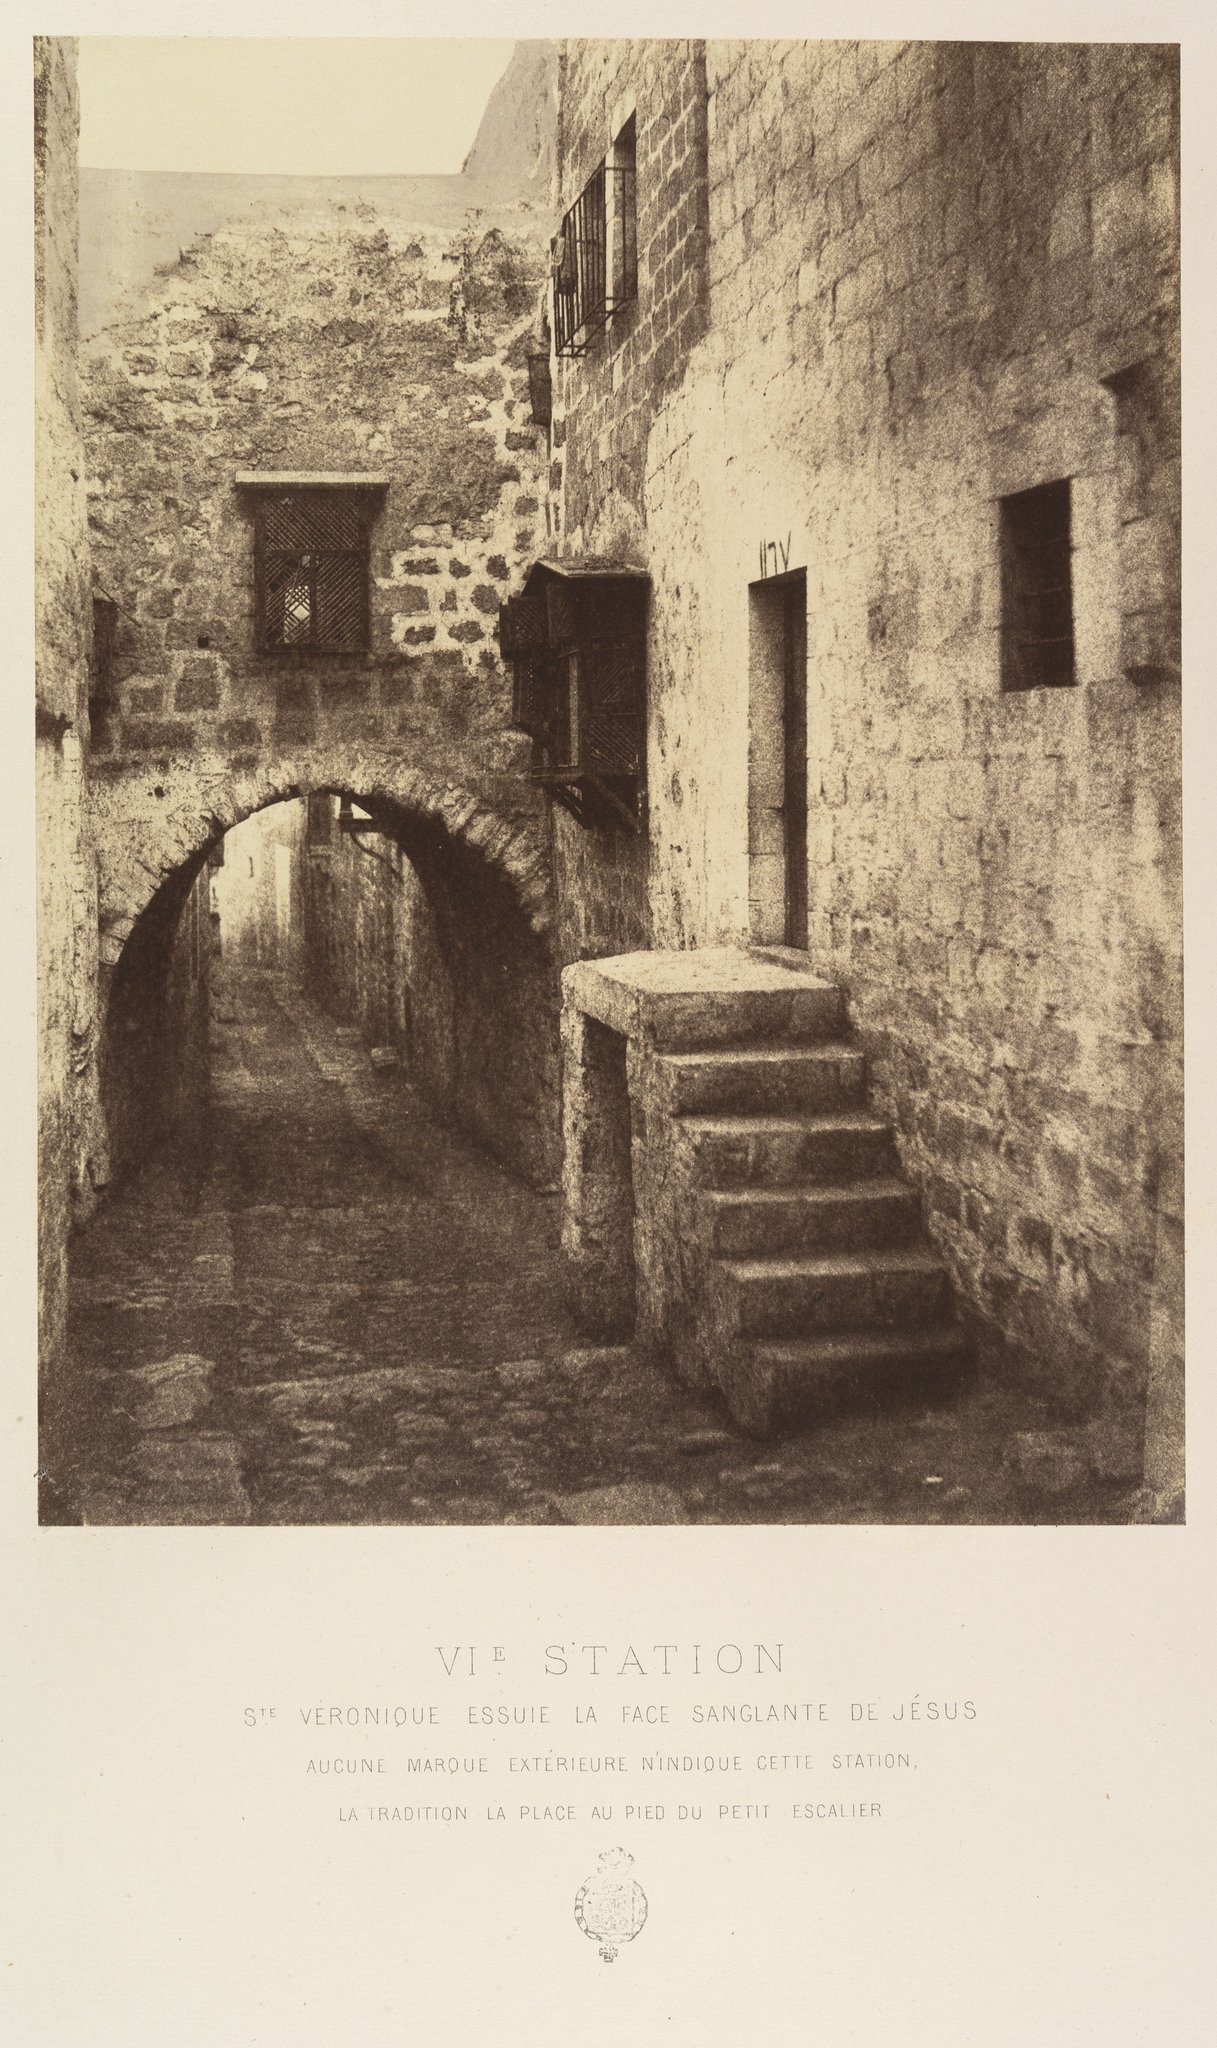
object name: photograph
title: VIe Station. Ste Véronique essuie la face sanglante de Jésus. Aucune marque extérieure n'indique cette station. La tradition la place au pied du petit escalier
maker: louis de clercq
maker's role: artist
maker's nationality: french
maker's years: 1837-1901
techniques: albumen silver print, paper negative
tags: architecture,arches,stairs